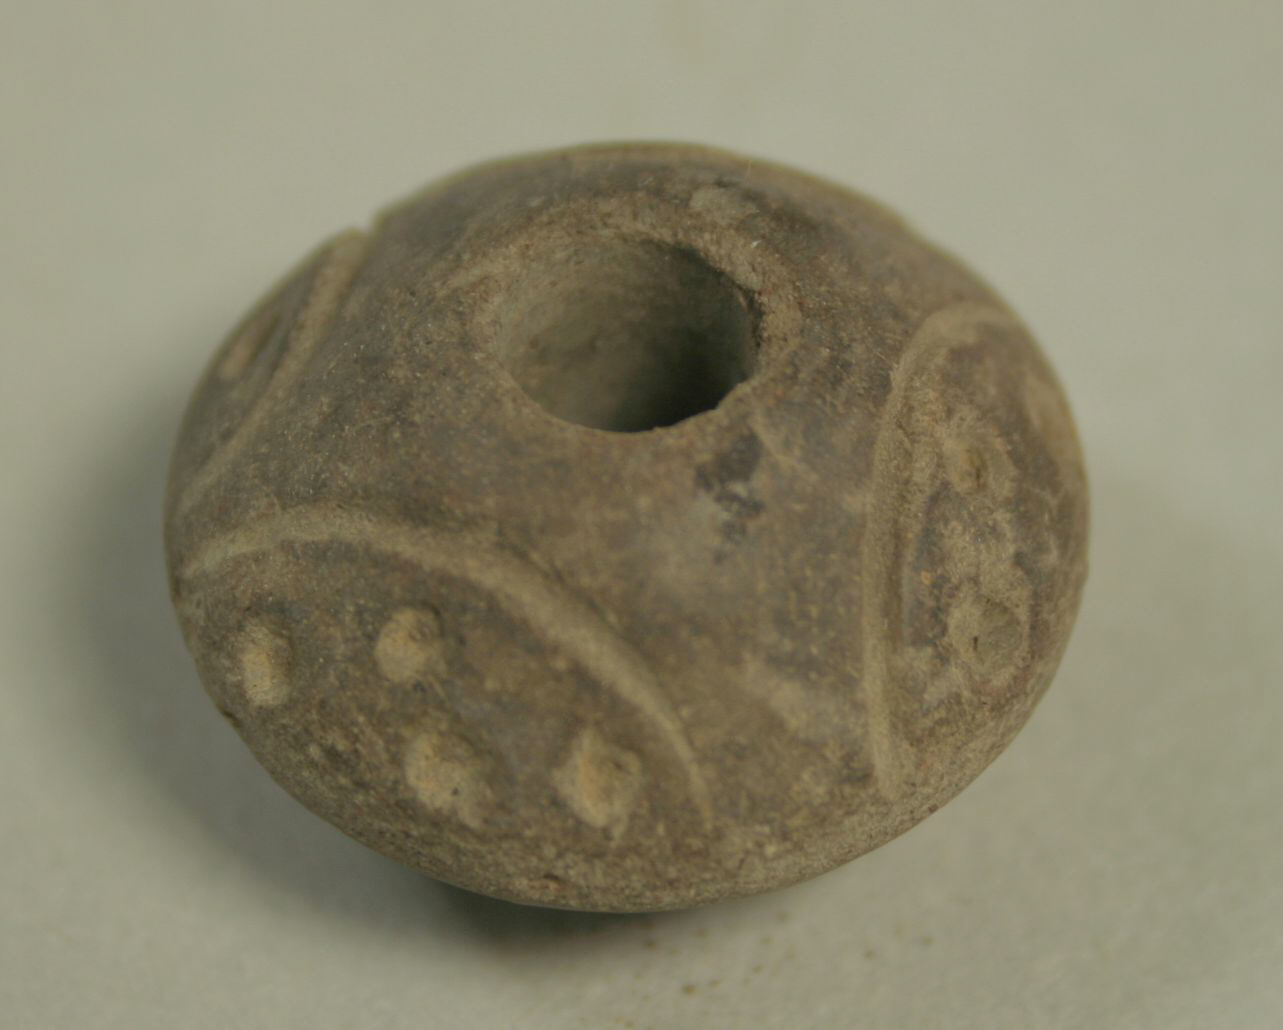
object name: spindle whorl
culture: peruvian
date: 901-1600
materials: ceramic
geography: peru